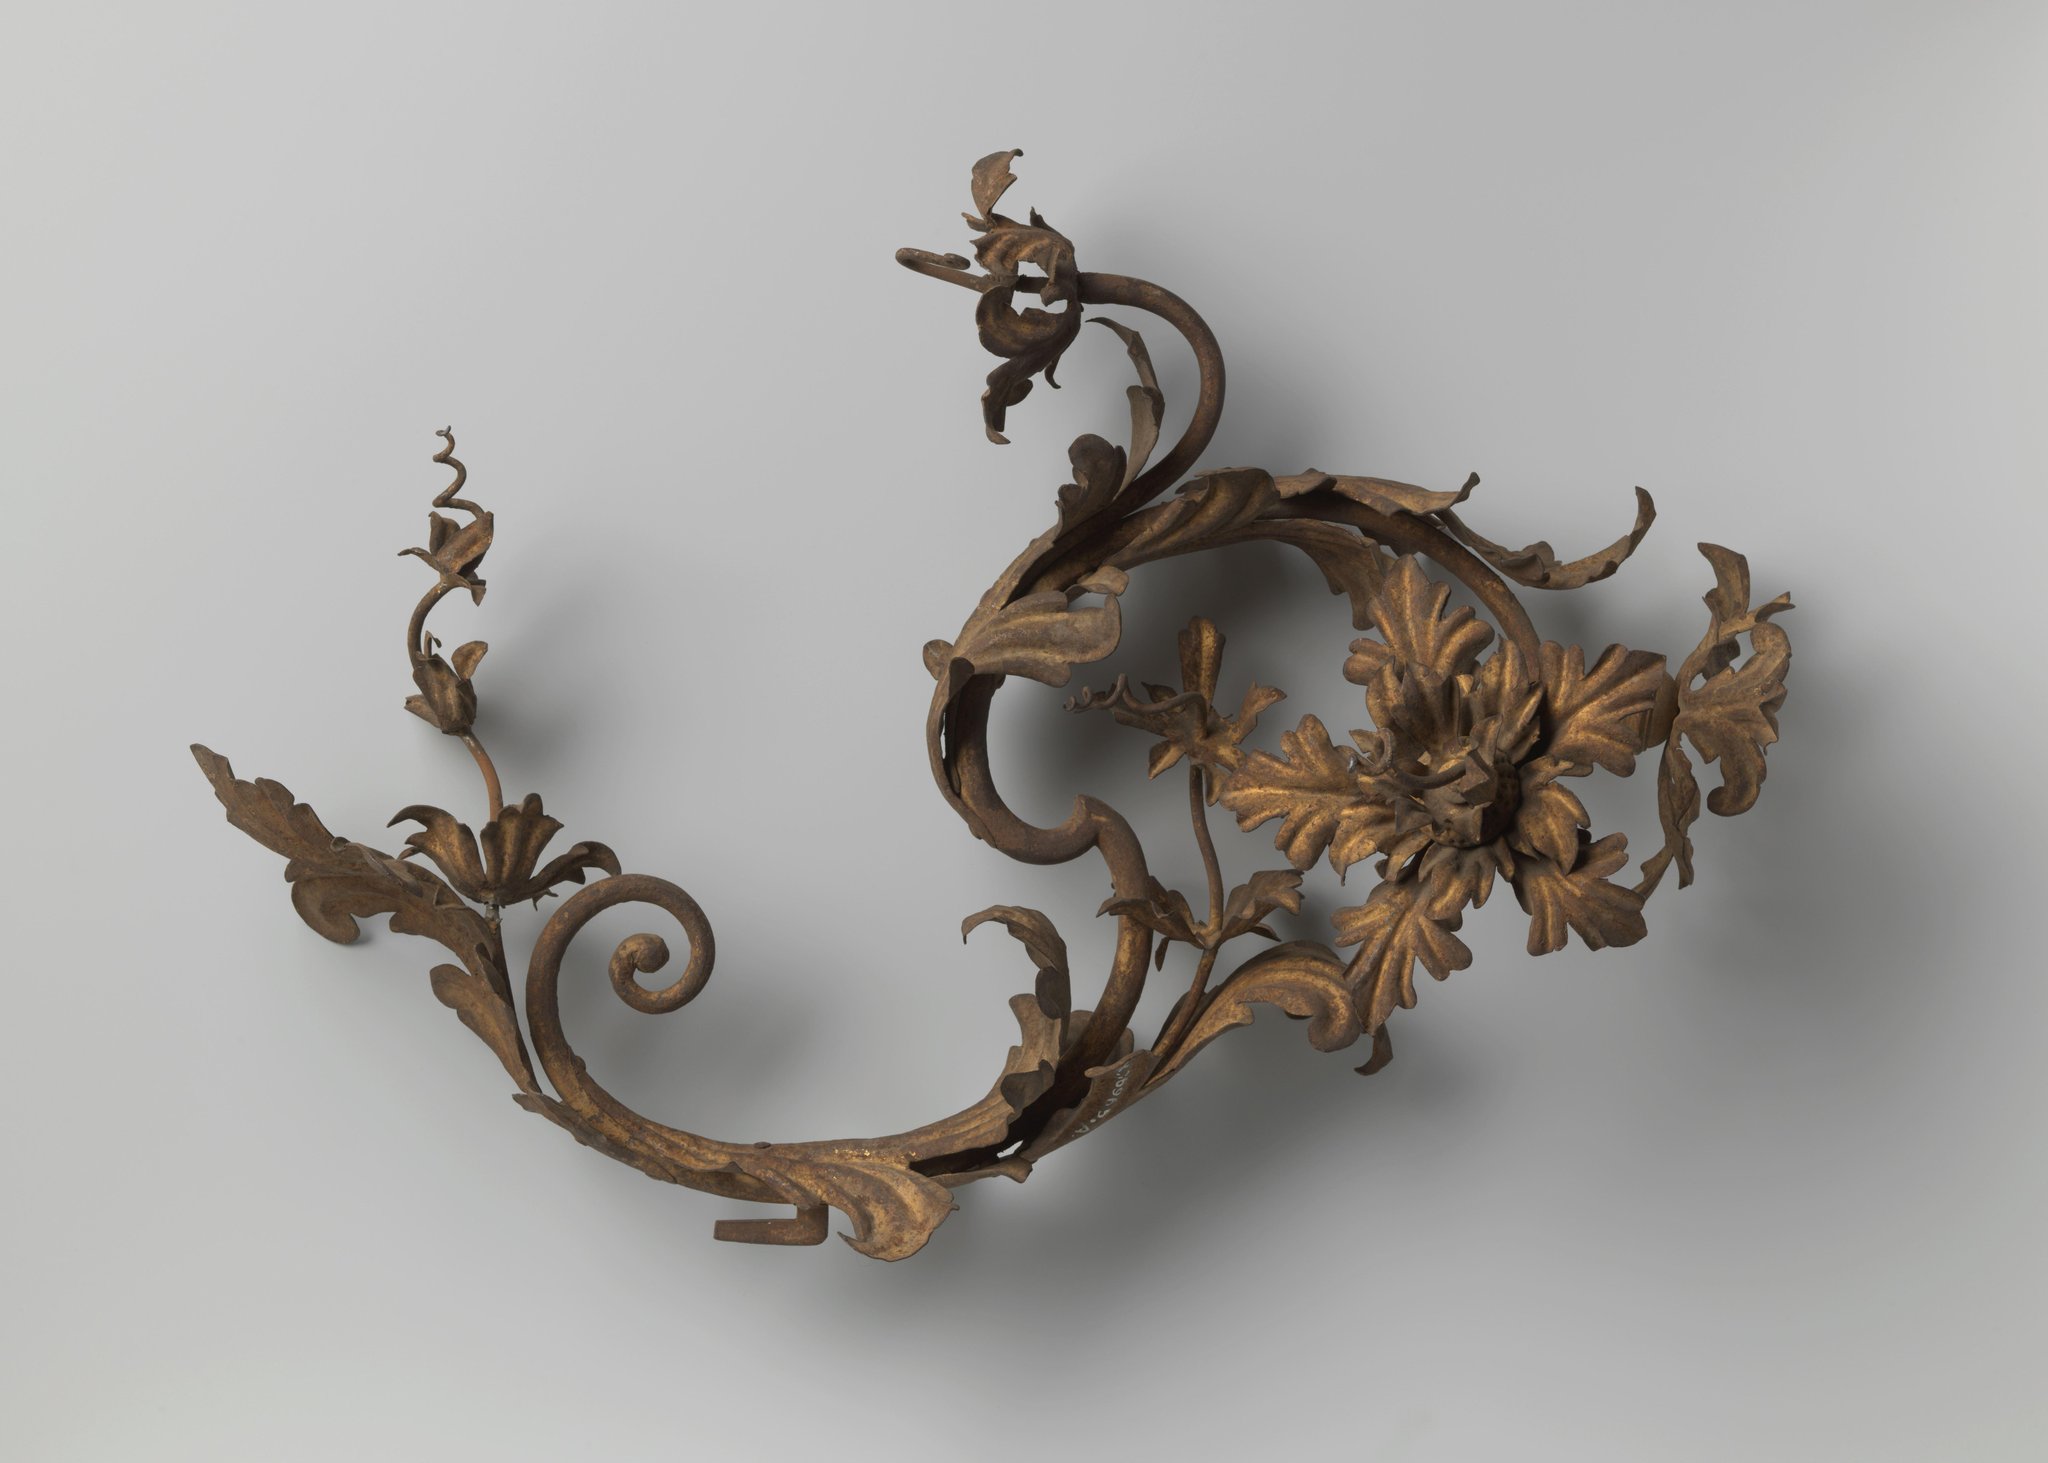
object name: uithangarm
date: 1700-1800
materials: iron, wood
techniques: gilding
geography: italy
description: Een ijzeren uithangarm, gevormd uit twee boven elkaar, tegenzijdig geplaatste C-voluten die onder in een krul en boven in een grote, naar een zijde gerichte bloem eindigen. De voluut is versierd met bladeren en drie ranken. Een deel van de bloem is van hout, geheel verguld. Afkomstig uit de verzameling Dr. F. Mannheimer.